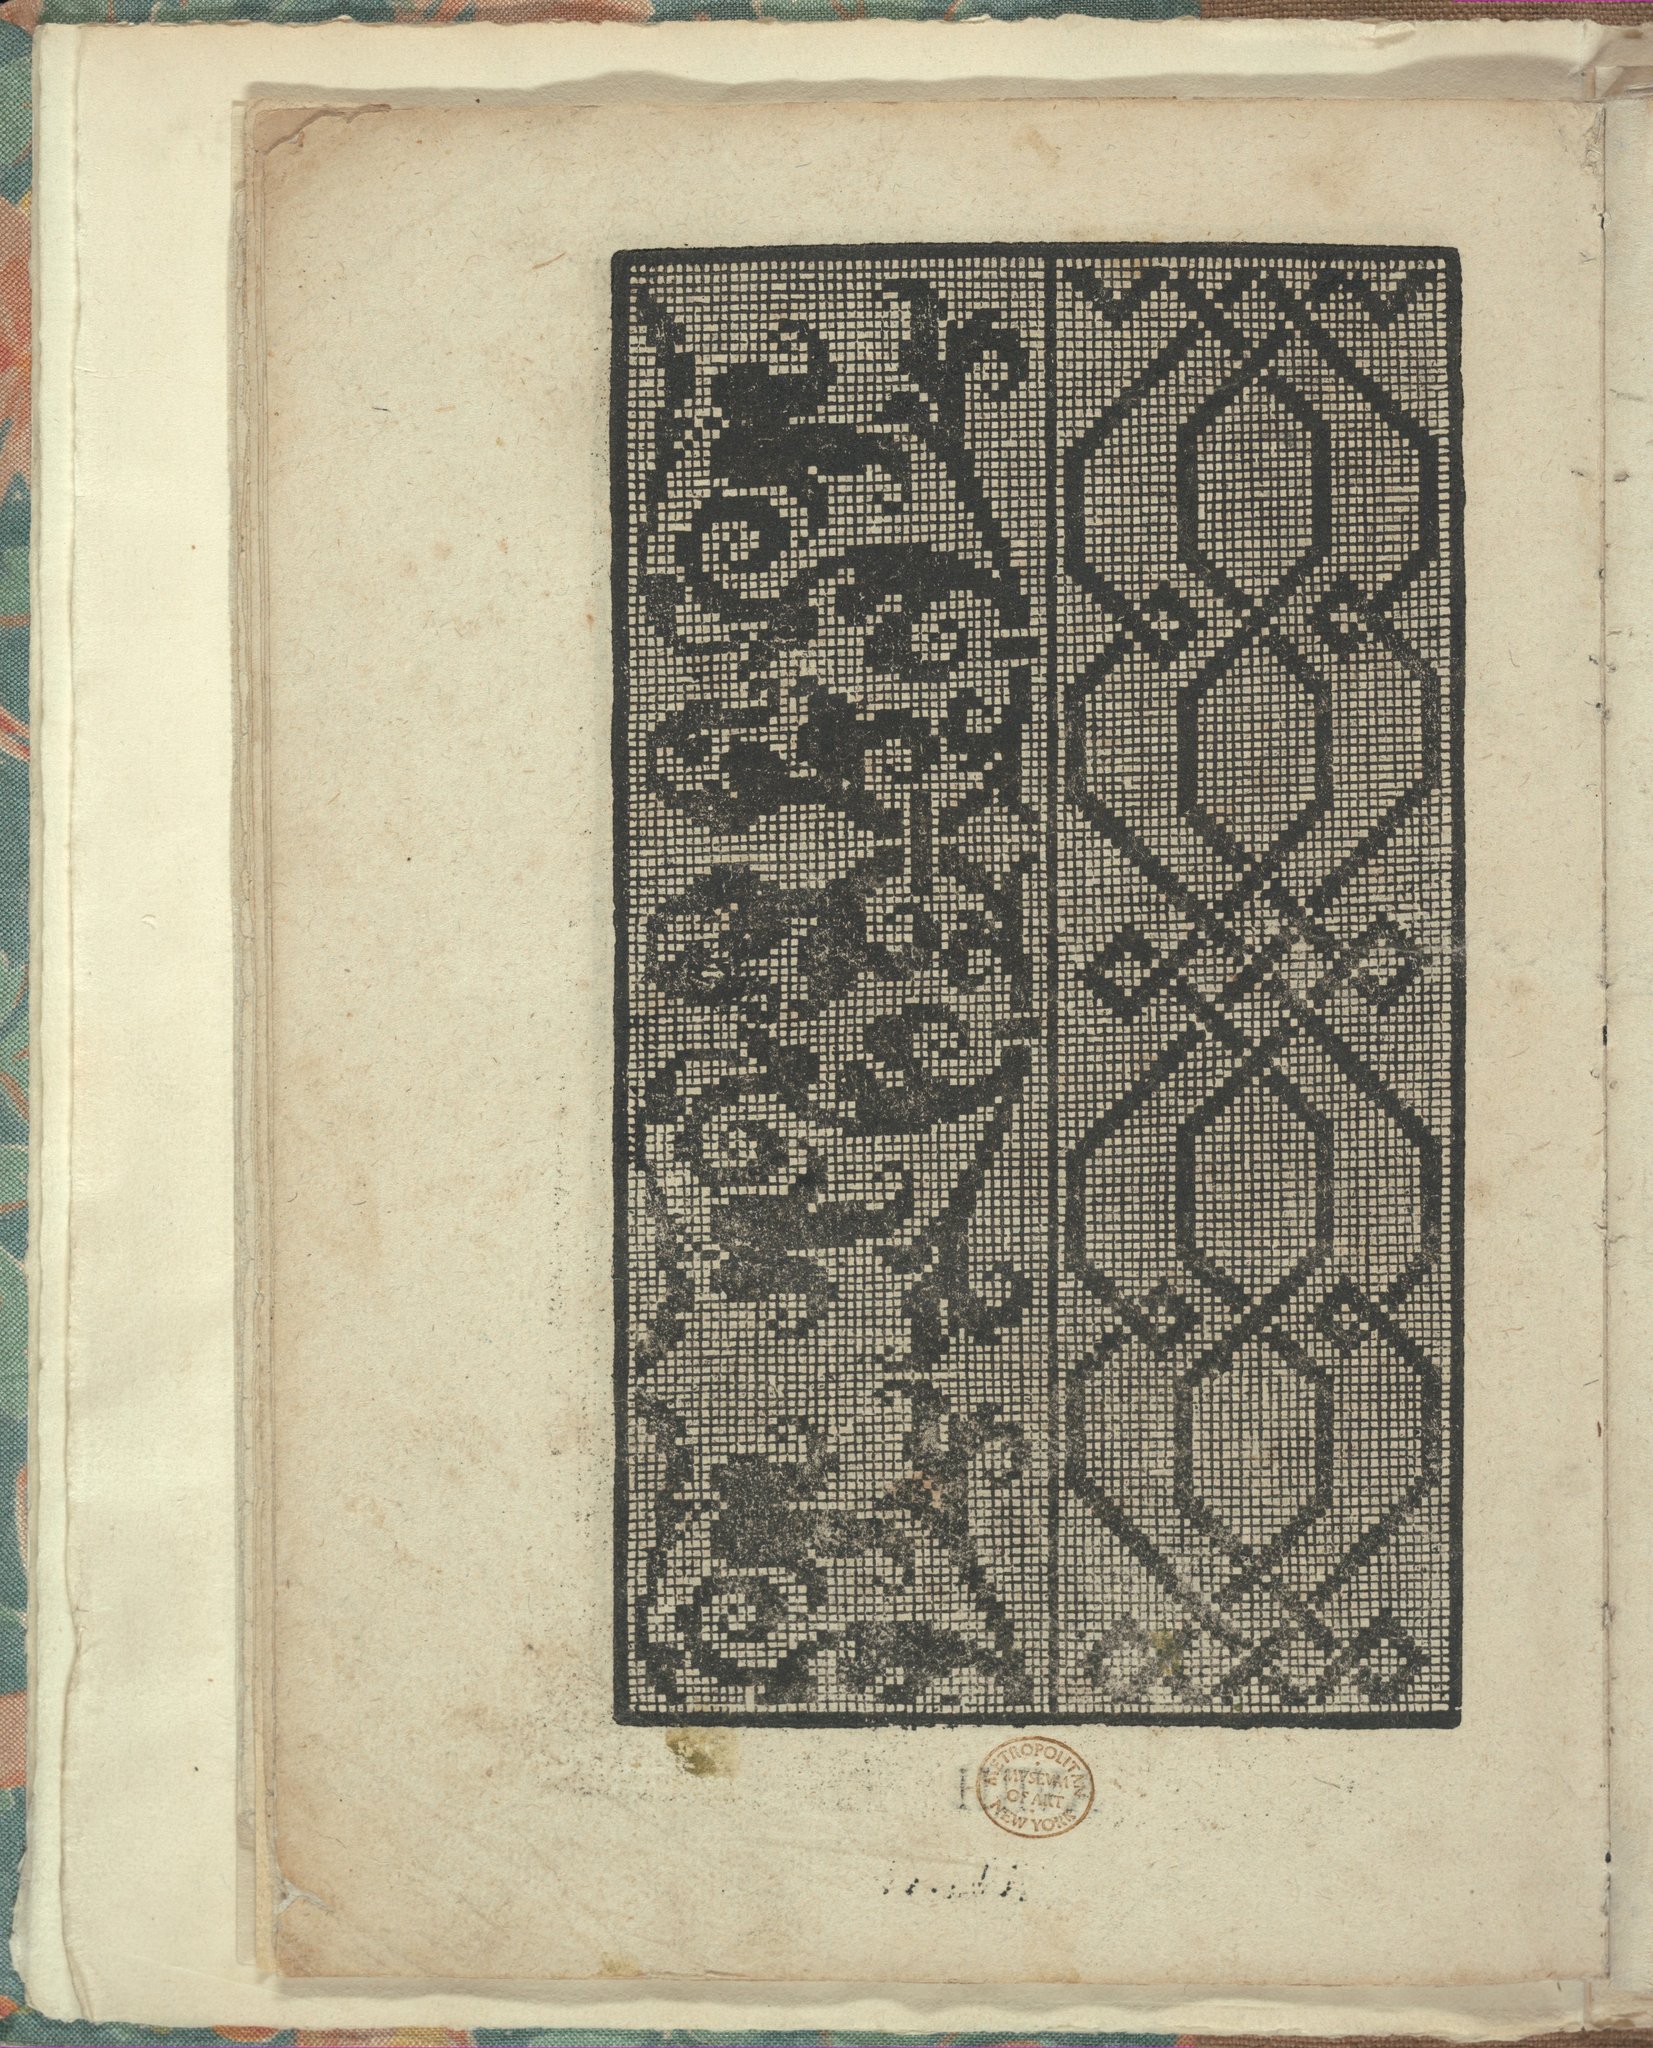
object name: book print ornament architecture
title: Opera Nova Universali intitulata Corona di racammi, page 9 (verso)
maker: giovanni andrea vavassore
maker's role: publisher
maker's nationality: italian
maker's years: 1530-1573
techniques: woodcut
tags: ornament